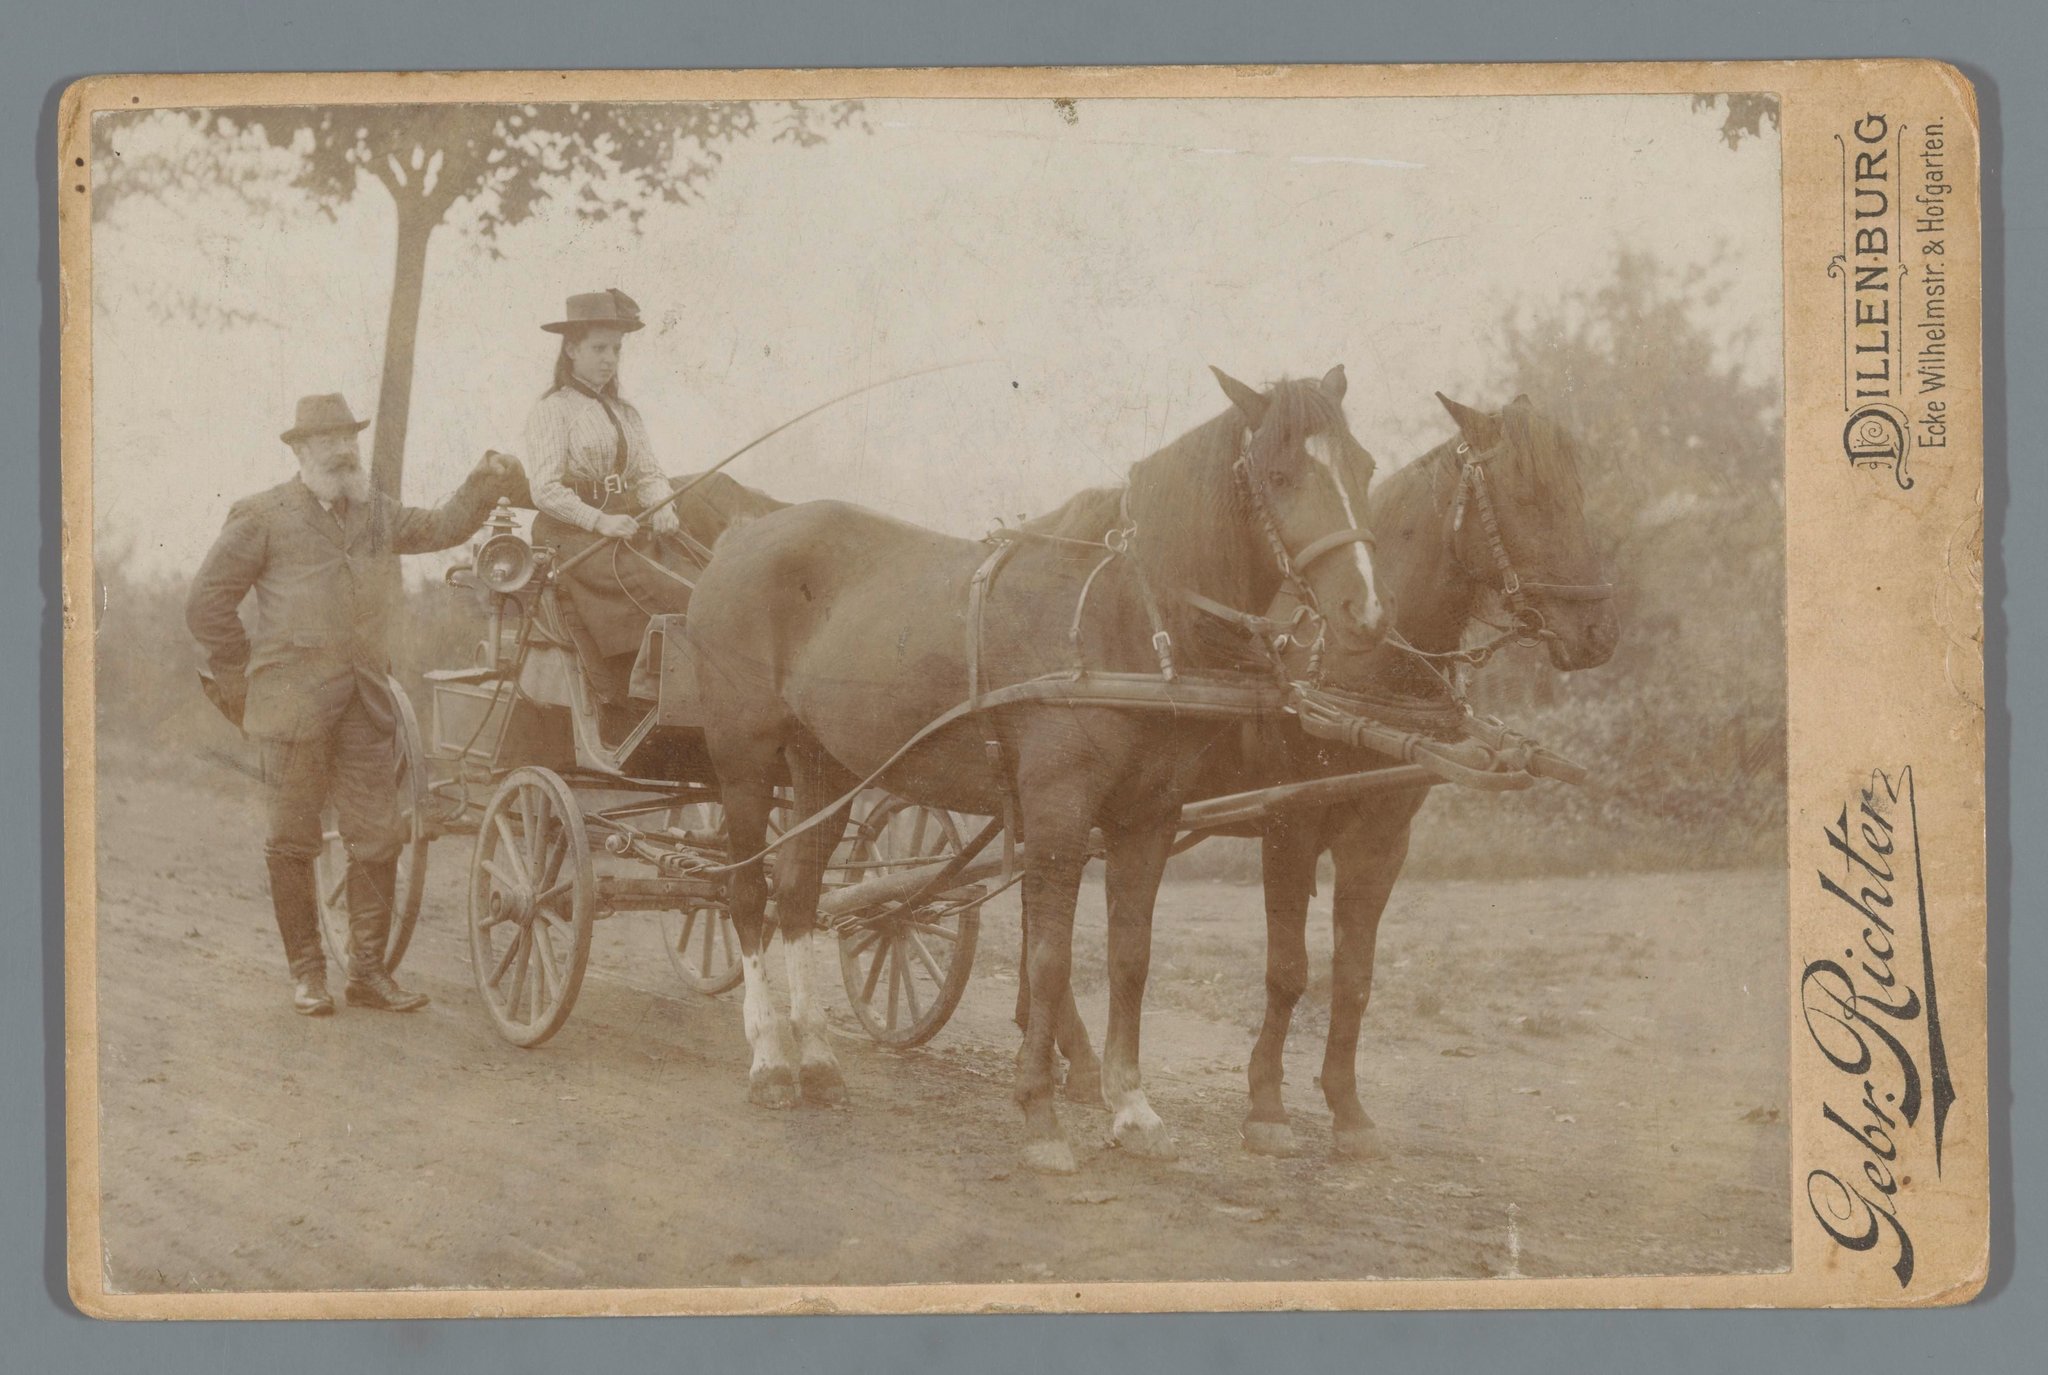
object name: photograph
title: Onbekende man en een meisje op een paardenkoets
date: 1890-1910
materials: cardboard, photographic support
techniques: gelatin silver print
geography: dillenburg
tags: adolescent, young woman, maiden, four-wheeled, animal-drawn vehicle, e.g.: cab, carriage, coach, horse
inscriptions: inscription: ‘Photograph. Atelier (...) Die Platten bleiden für Nachbestellungen aufbewahrt.’